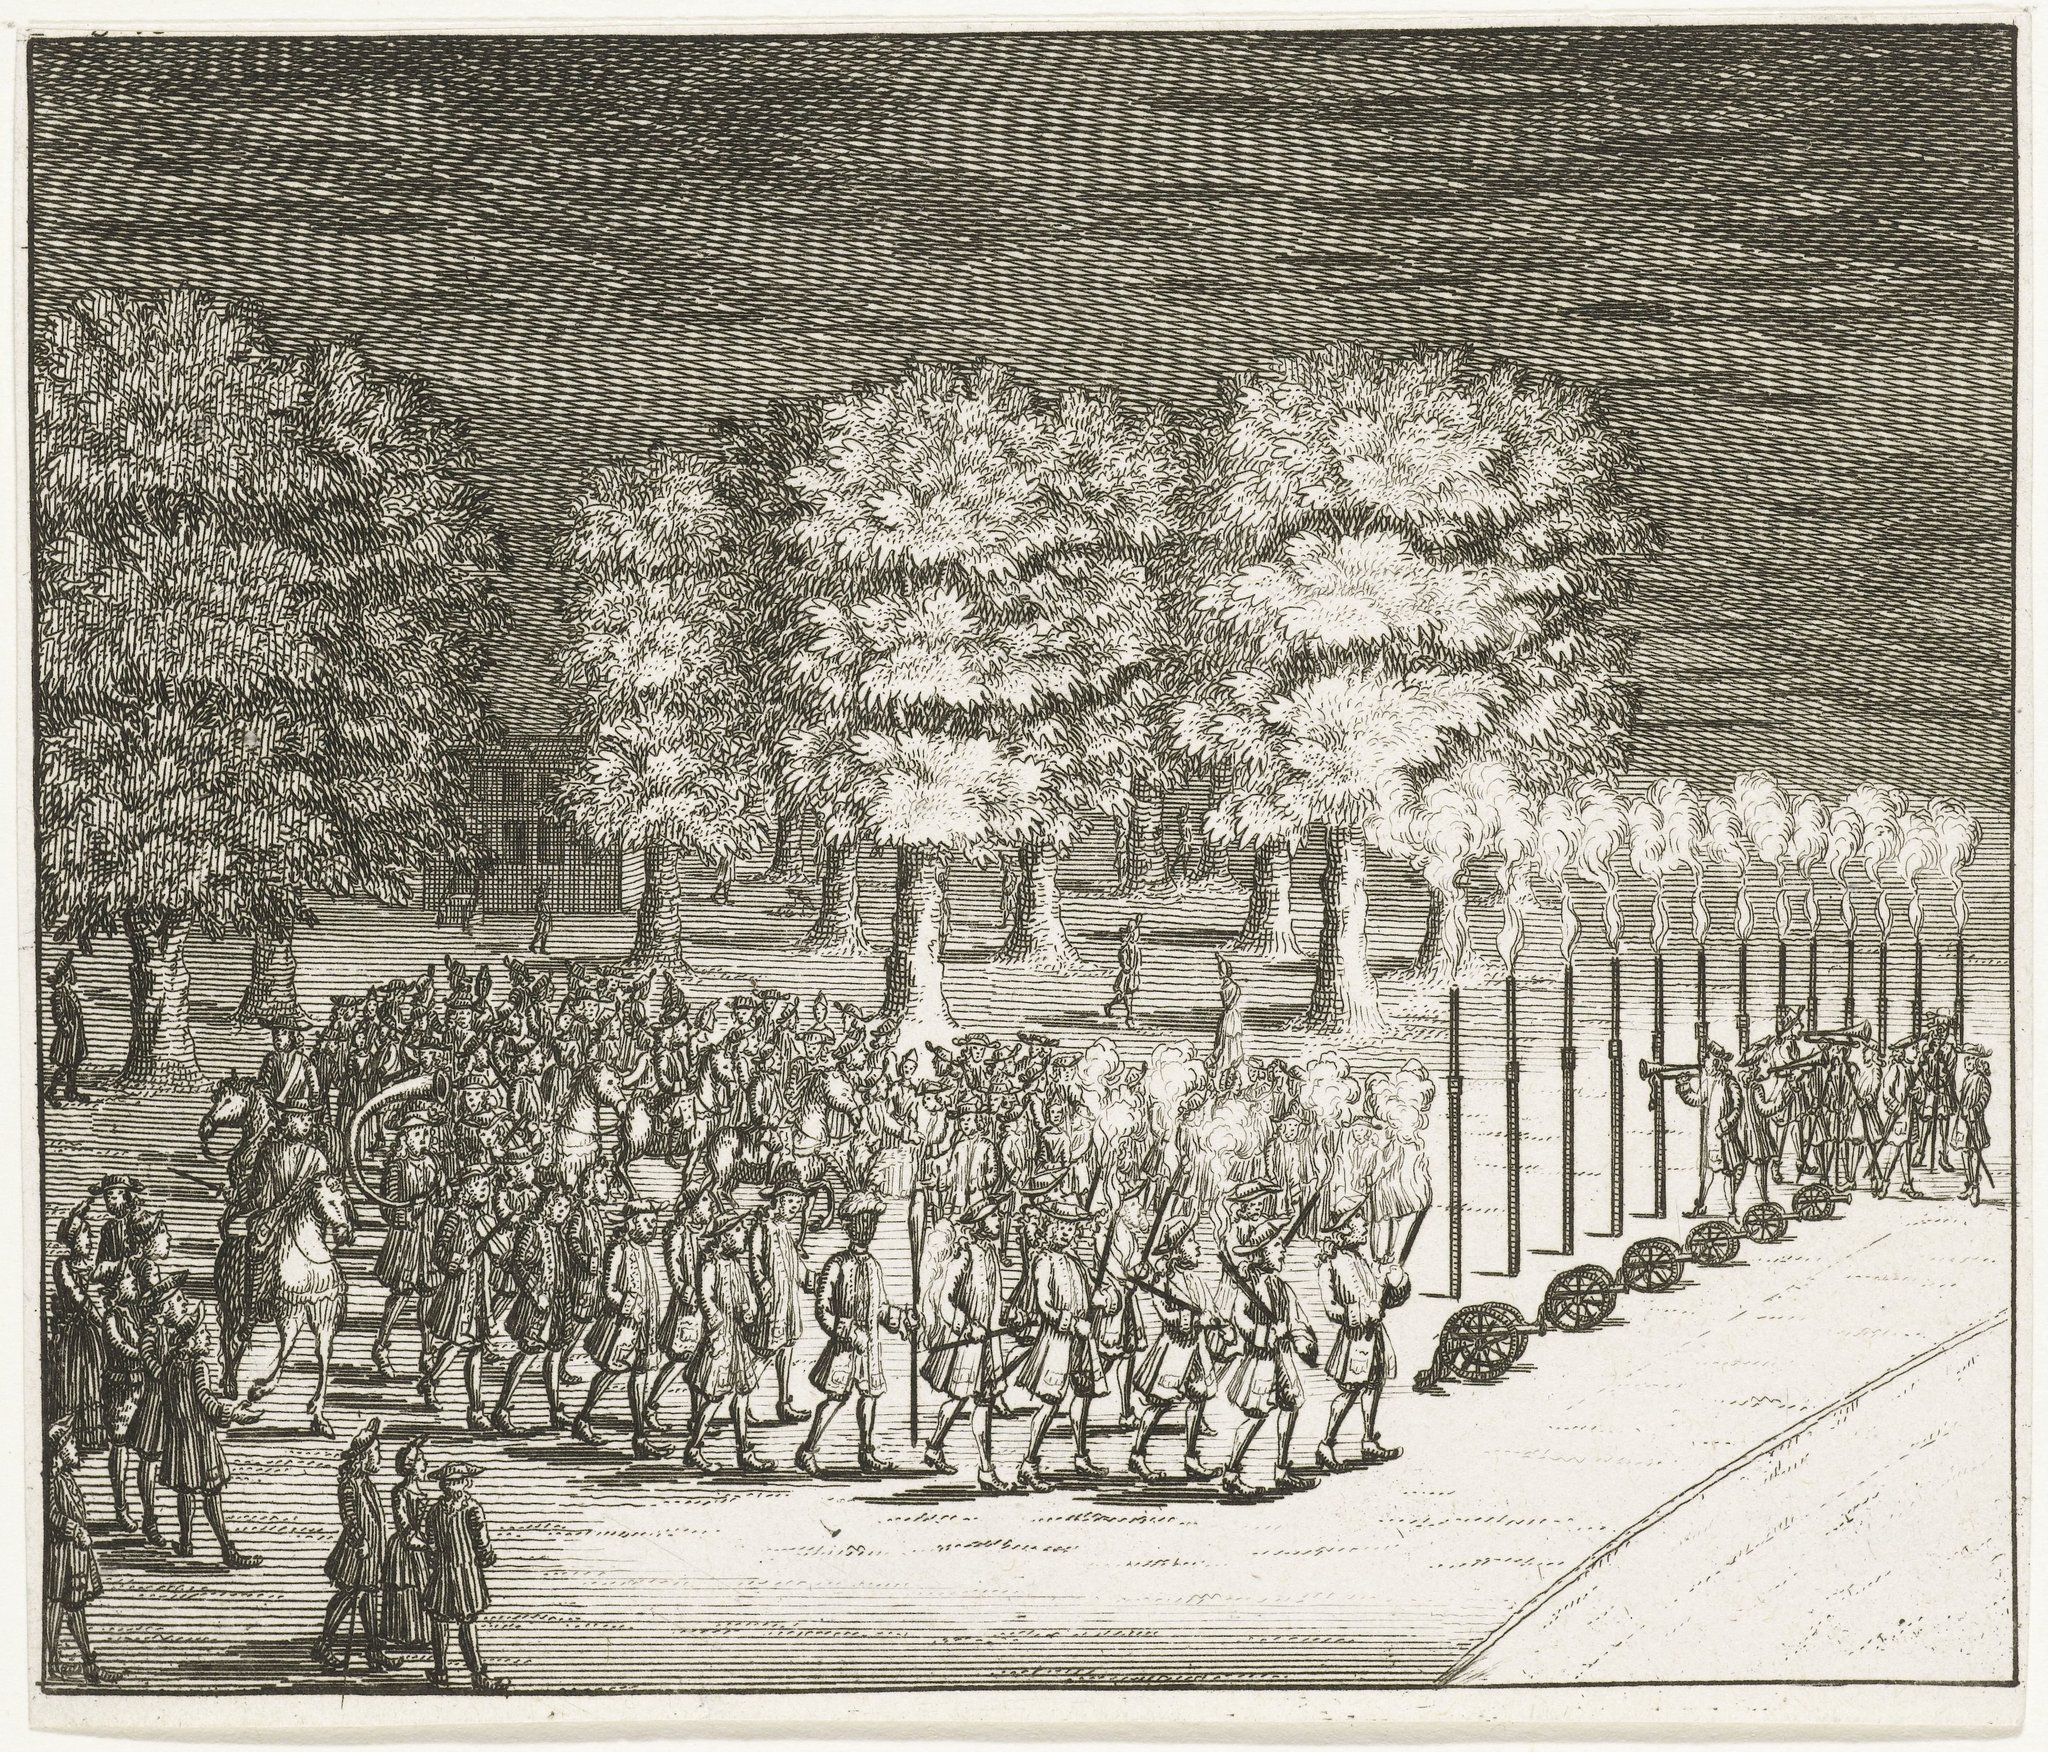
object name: print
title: Optocht met fakkels en muziek, 1714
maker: Anonymous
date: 1714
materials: paper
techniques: etching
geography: northern netherlands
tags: public festivities at birth of royal persons (+ parade, pageant, cavalcade ~ festive activities)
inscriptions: collector's mark: Lugt 2228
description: Optocht met fakkels en muziek op de Maliebaan te Utrecht, met toortsen en kanonnen voor saluutschoten, 1714. Onderdeel van een groep van twaalf illustraties van de feestelijkheden georganiseerd in Utrecht in 1714 door de Portugese graaf Joao Gomes da Silva conde de Tarouca ter ere van de geboorte van twee Portugese prinsjes van koning Johan V.